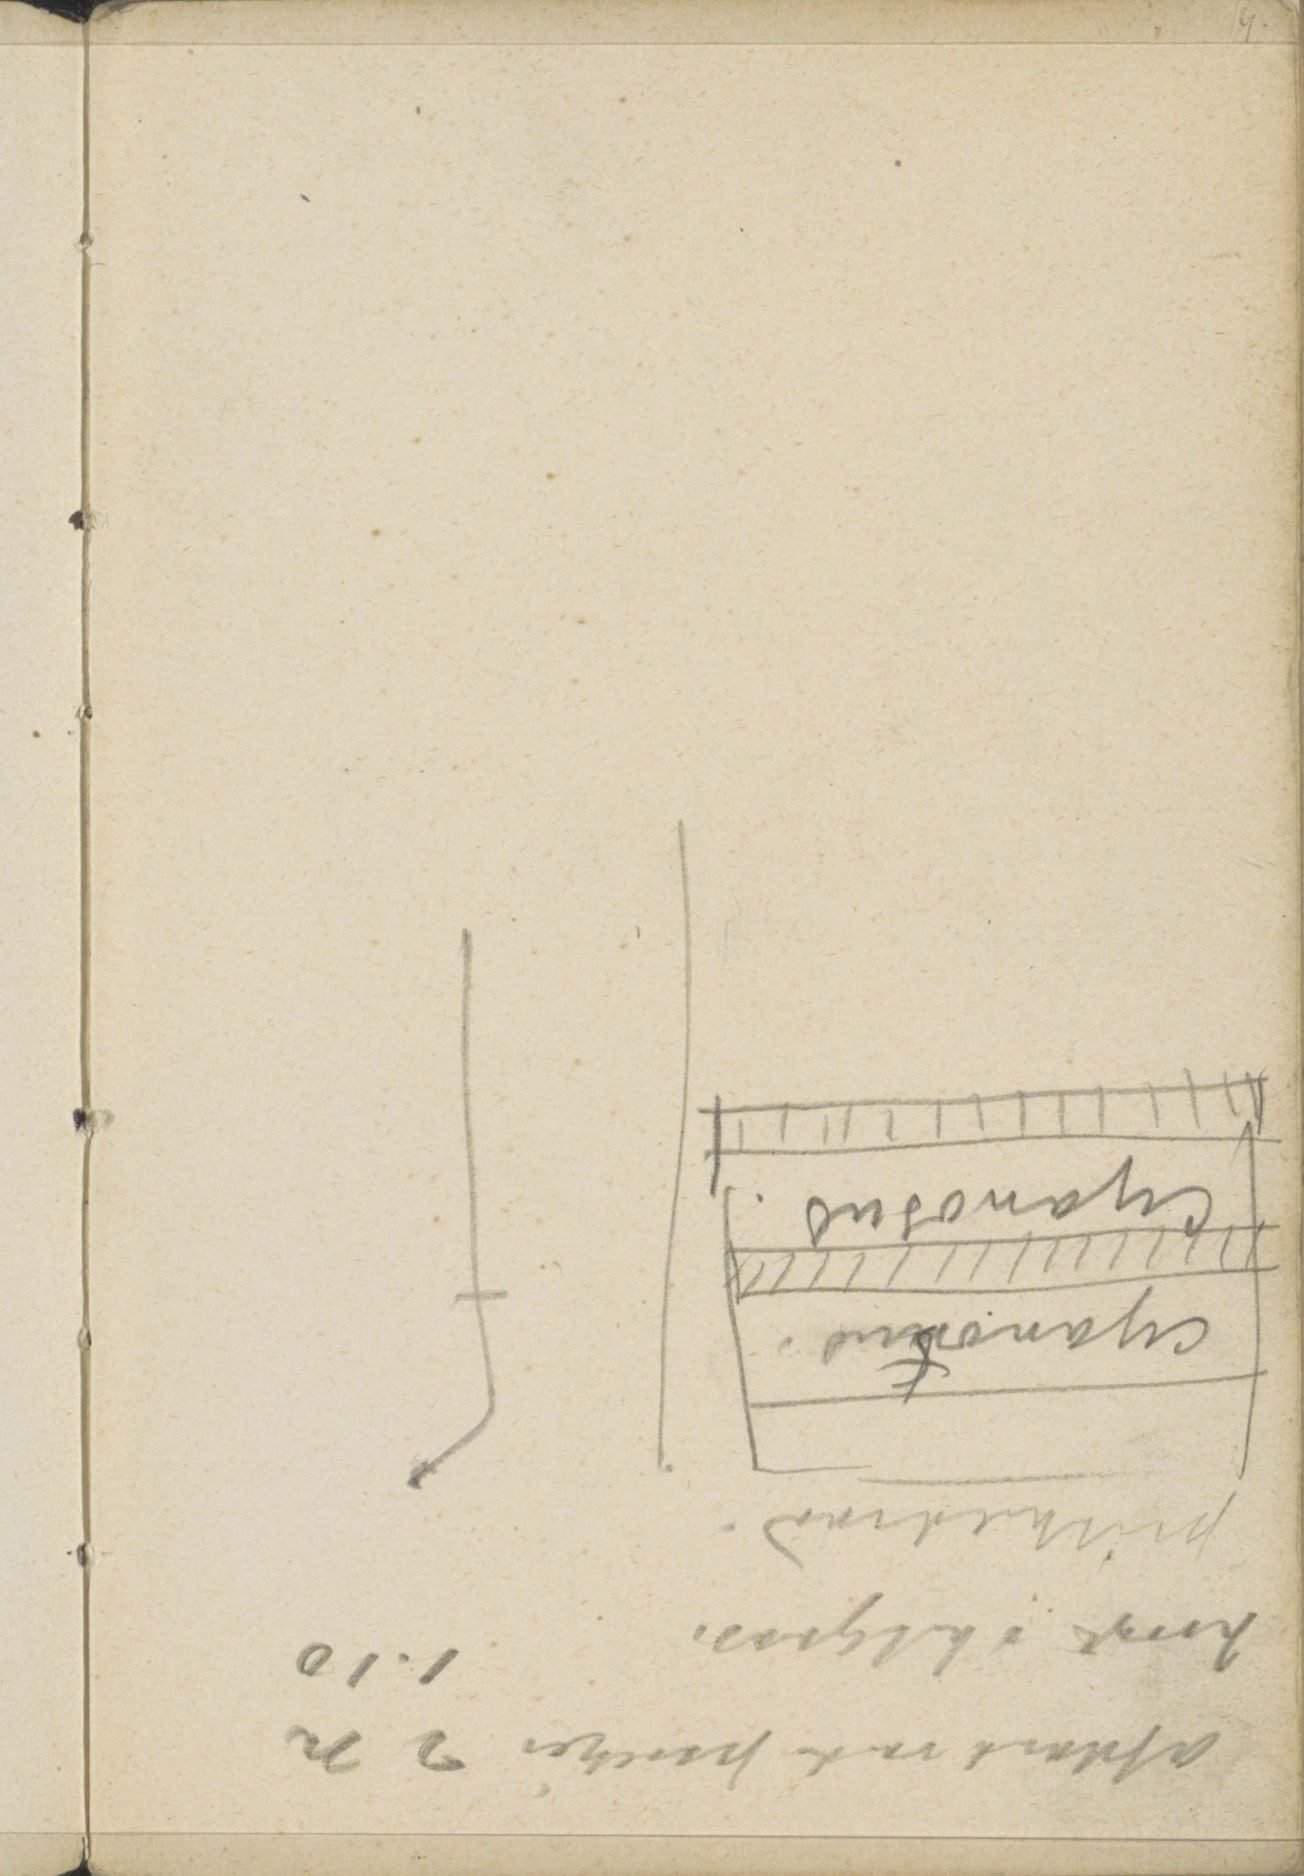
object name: sketchbook leaf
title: Studies en annotaties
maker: george hendrik breitner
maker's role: draughtsman, painter, print maker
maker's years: 1857-1923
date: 1903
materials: paper, pencil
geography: amsterdam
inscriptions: annotation: ‘[...] Cyanosus’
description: Studies en annotaties. Pagina 4 uit een schetsboek met 46 bladen vervaardigd te Amsterdam en Haarlem.